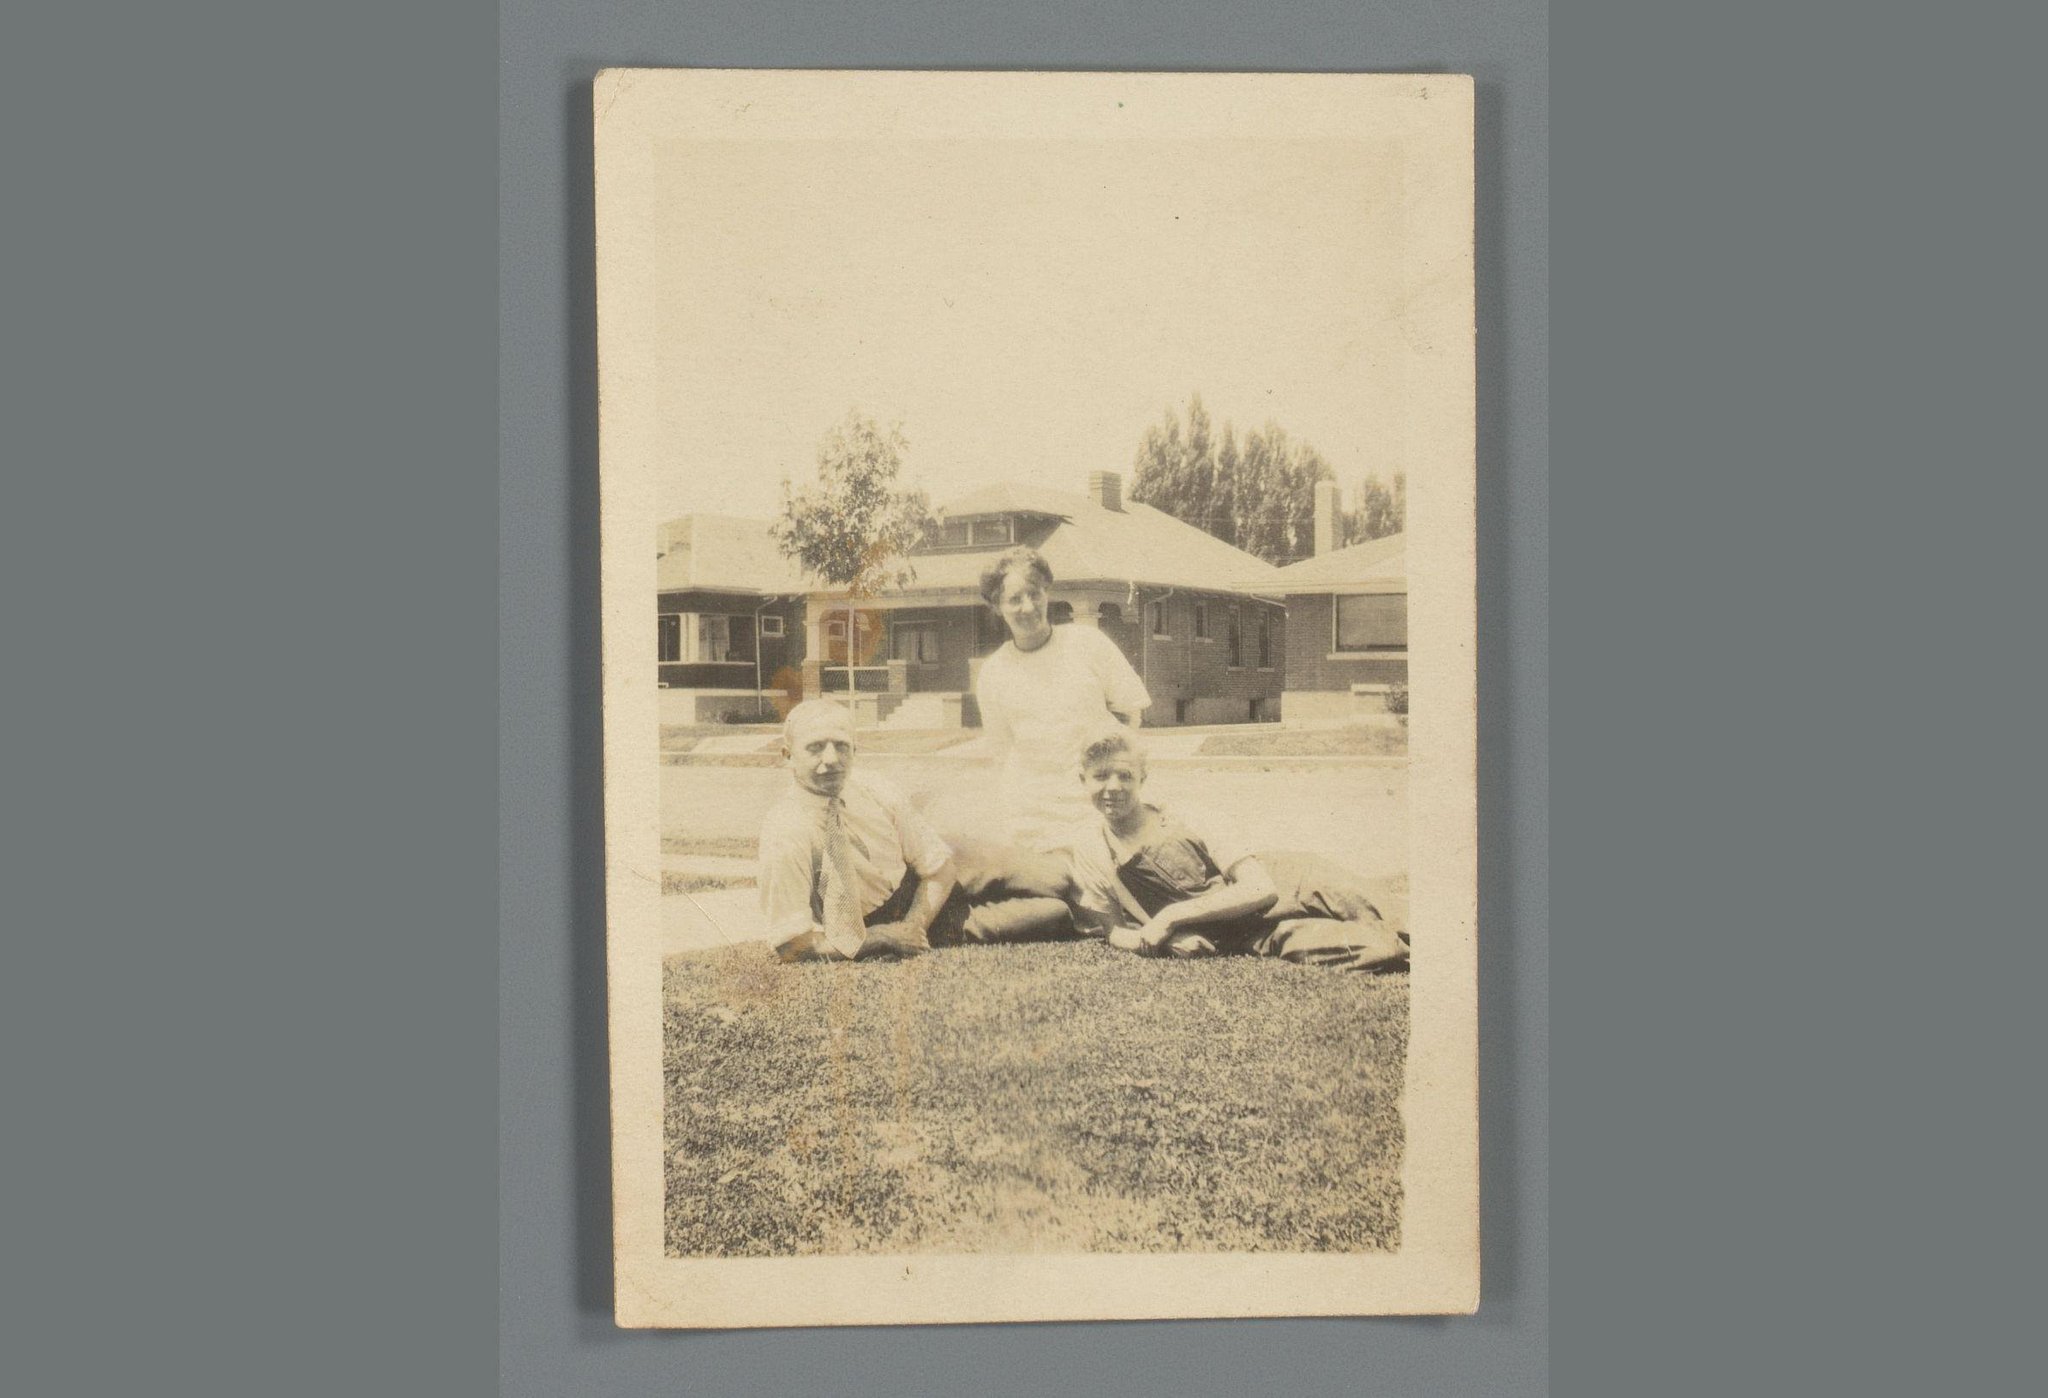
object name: photograph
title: Groepsportret van een onbekende man, vrouw en kind in een woonwijk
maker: Anonymous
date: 1930-1960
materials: paper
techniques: gelatin silver print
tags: family group, especially parents with their child(ren), detached house in city, historical persons not known by name